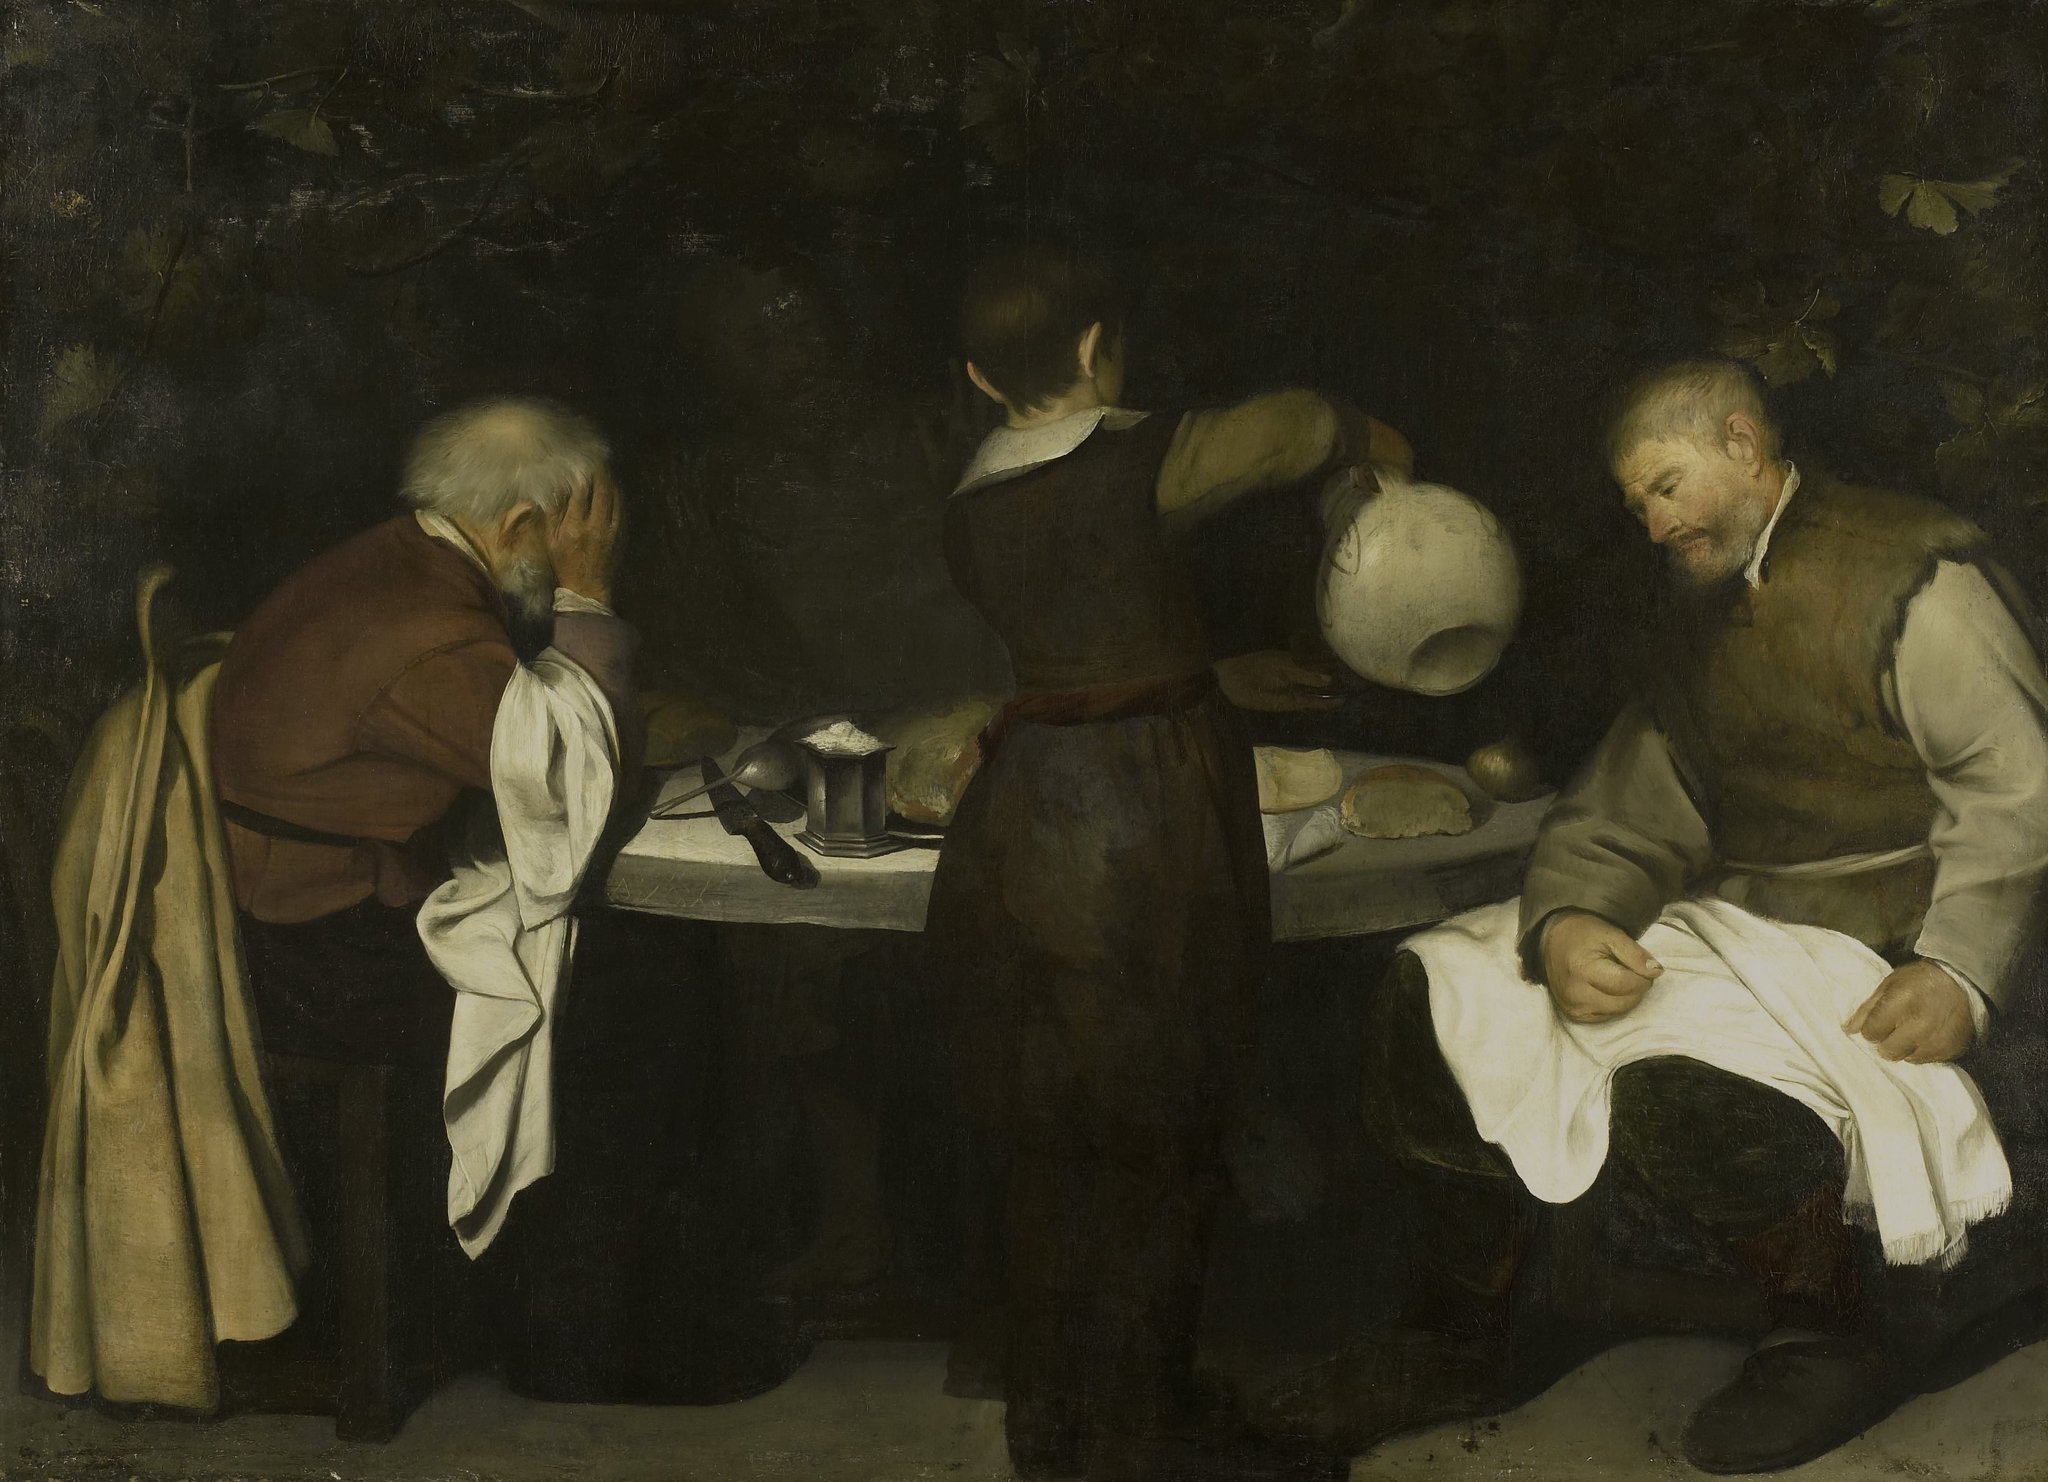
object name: painting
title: Supper at Emmaus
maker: Anonymous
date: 1620-1680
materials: canvas, oil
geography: spain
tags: christ vanishes ~ supper at emmaus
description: De Emmaüsgangers. Aan weerszijden van een tafel zitten twee mannen aan een maaltijd, tussen hen in een schim van Christus. Voor de tafel schenkt een staande jongen uit een kan.